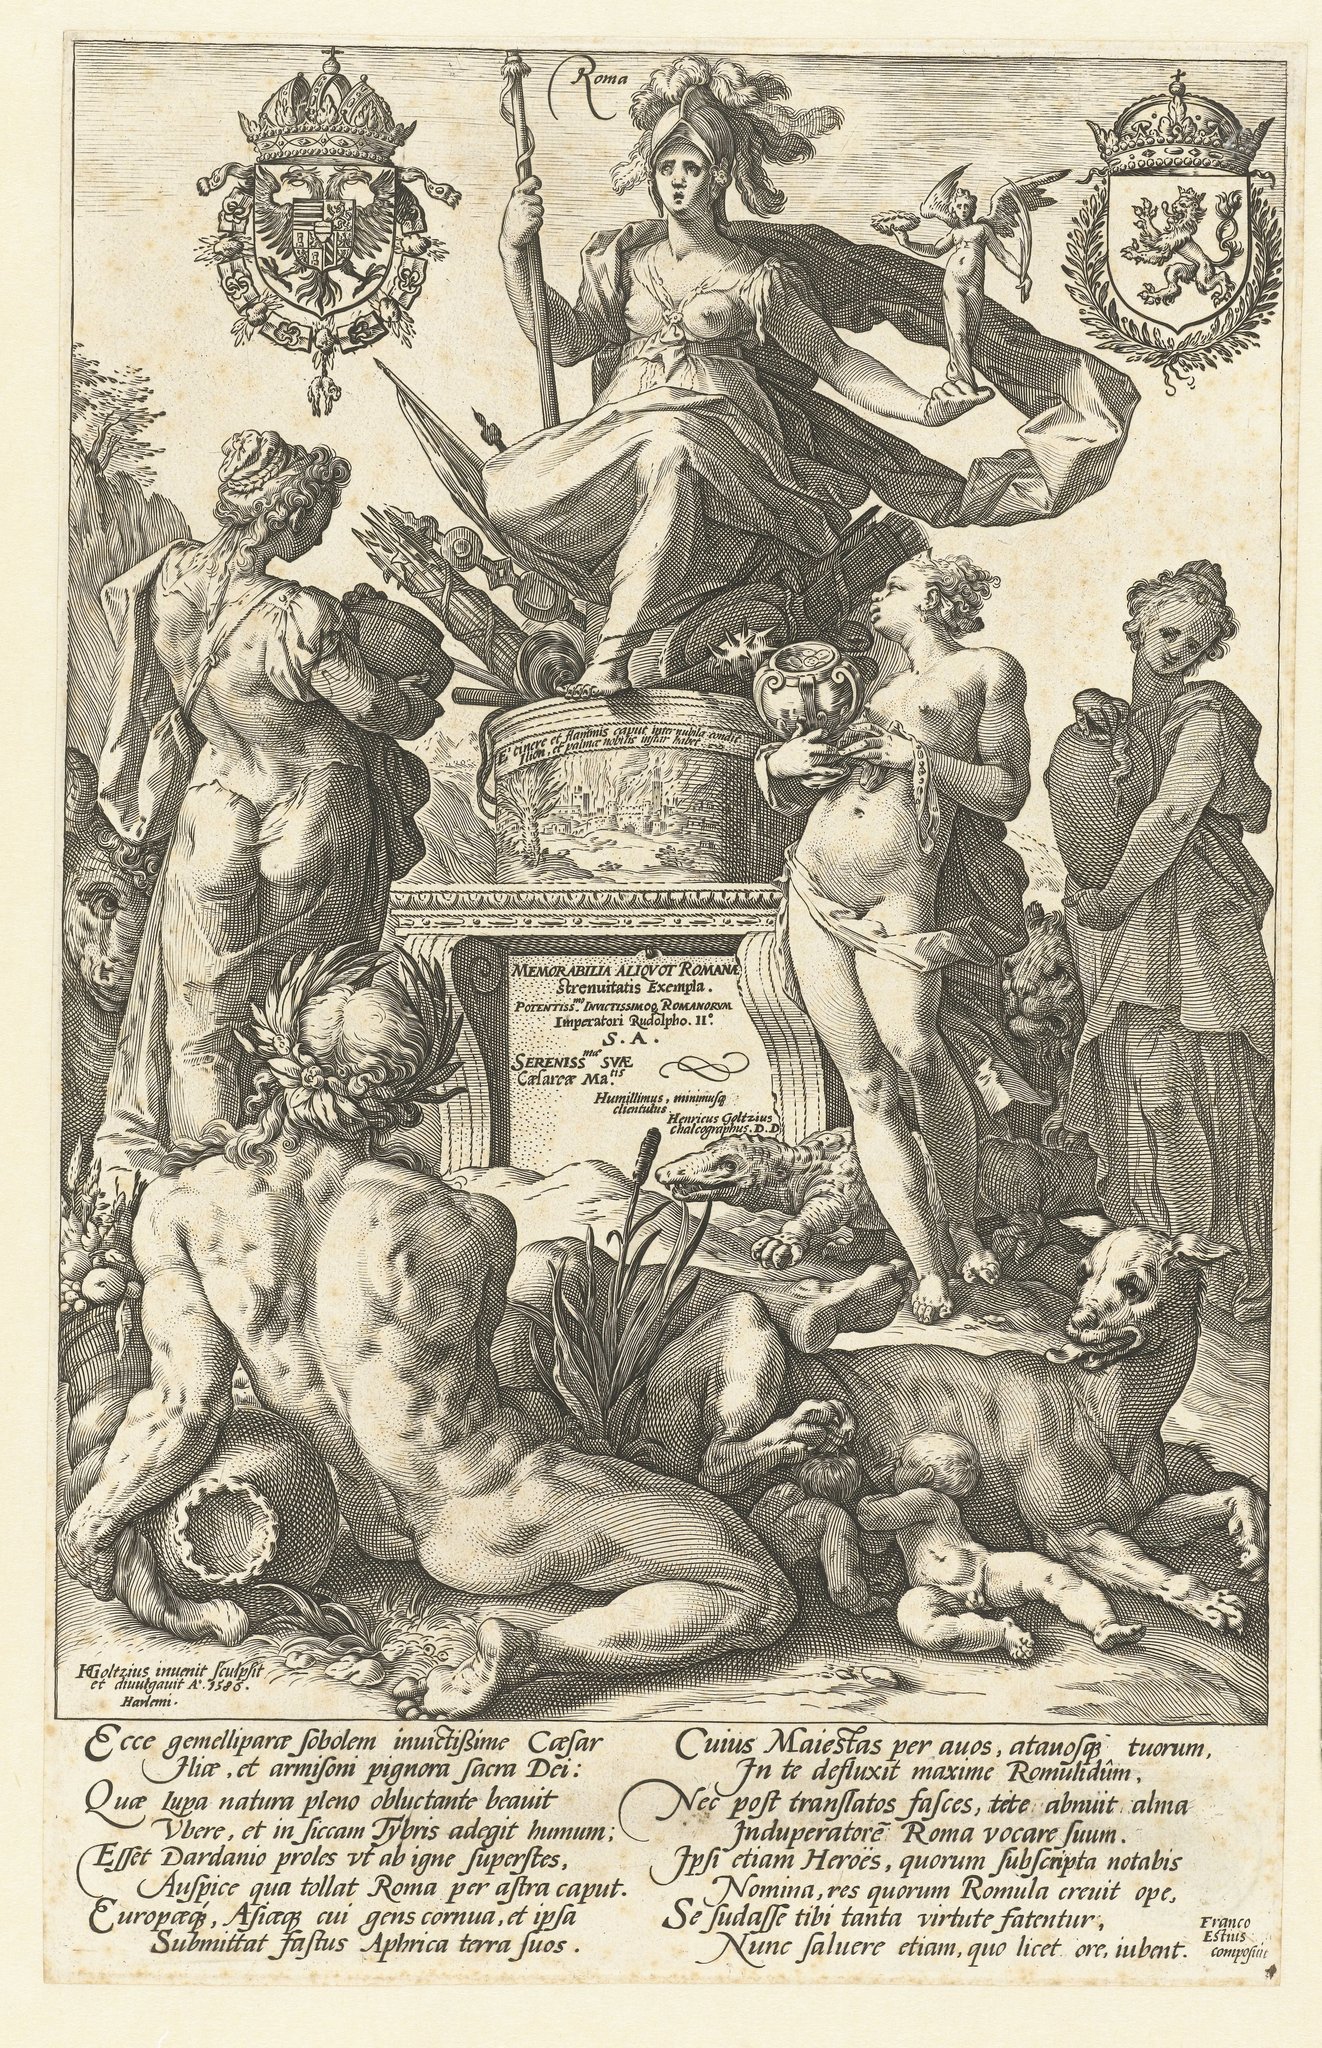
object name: print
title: Titelprent voor prentserie De Romeinse helden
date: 1586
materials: paper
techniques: engraving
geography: haarlem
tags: europe represented allegorically; 'europa' (ripa), asia represented allegorically; 'asia' (ripa), africa represented allegorically; 'africa' (ripa), romulus and remus are washed ashore and suckled by a she-wolf; 'lupa romana', rome (one of the four world empires)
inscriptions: collector's mark: Lugt 10, collector's mark: ‘Hinloopen’, collector's mark: Lugt 11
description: De godin Rome ('Roma'), gezeten op een zetel van wapens op een sokkel, in haar linkerhand een beeldje van de godin van de overwinning. Bij de sokkel staan een vrouw met een os (Europa), een vrouw met een leeuw (Azië) en een vrouw met een krokodil (Afrika). Op de voorgrond ligt de stroomgod van de Tiber en de wolvin die Romulus en Remus zoogt. Onder de voorstelling twee coupletten van acht versregels in Latijn. Titelprent voor een serie van tien prenten, bestaand uit een ongenummerde titelprent, acht genummerde voorstellingen van helden en een ongenummerde afsluitende prent.